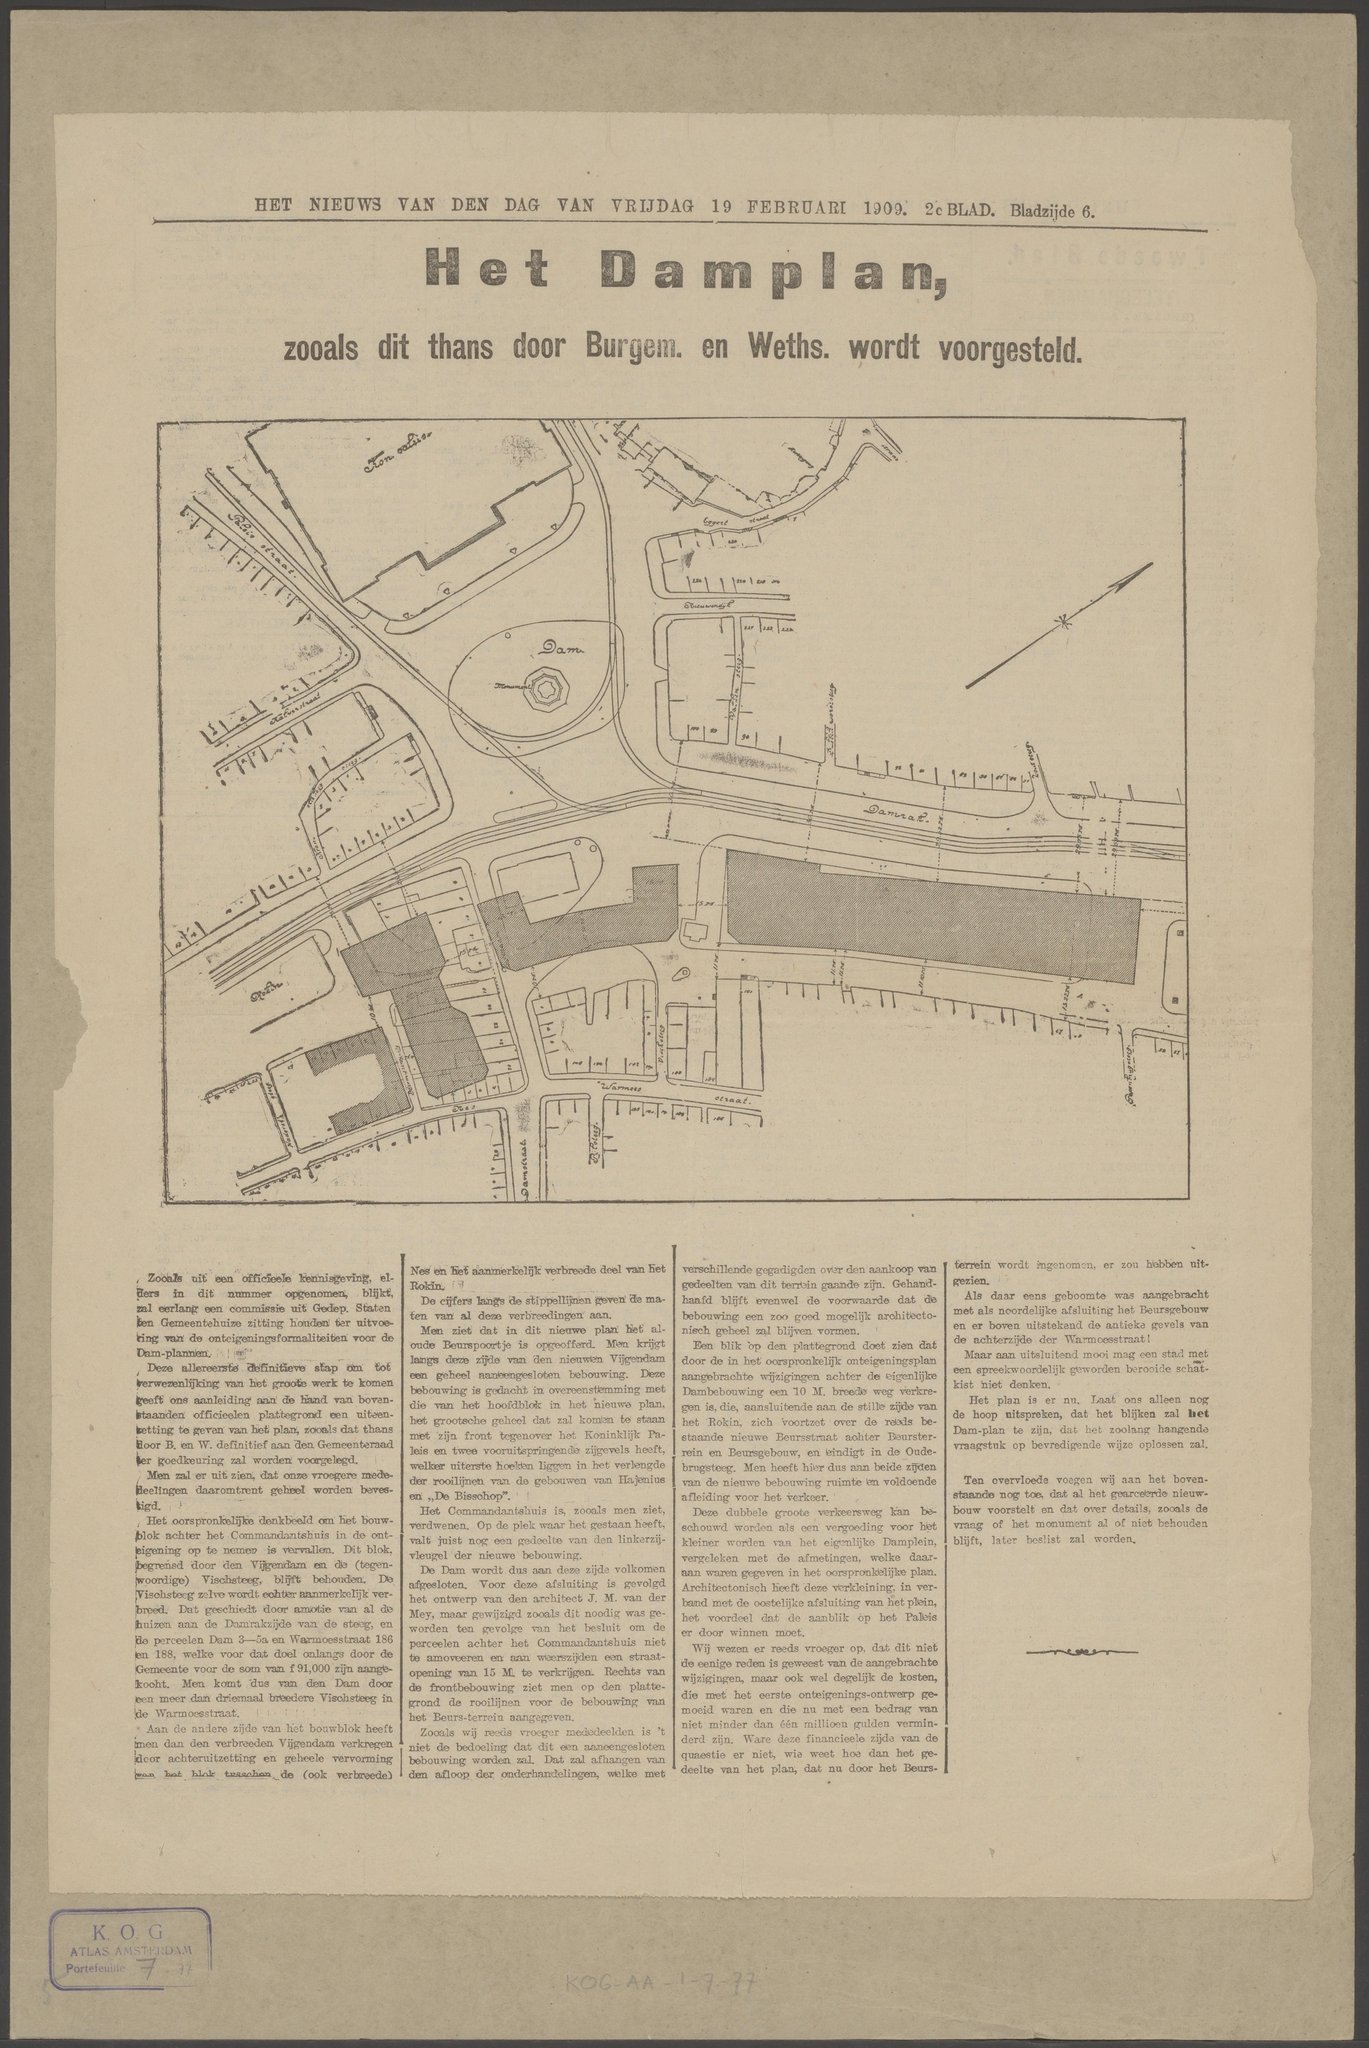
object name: area plan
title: Het Damplan, zooals dit thans door Burgem. en Weths. wordt voorgesteld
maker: Anonymous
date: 1909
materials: paper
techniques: letterpress printing, engraving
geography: amsterdam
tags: square, place, circus, etc., city-view in general; 'veduta', maps of cities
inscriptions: collector's mark: ‘7’ Lugt 1641b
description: Prent uit een onbekende publicatie, gepubliceerd op 19 februari 1909.